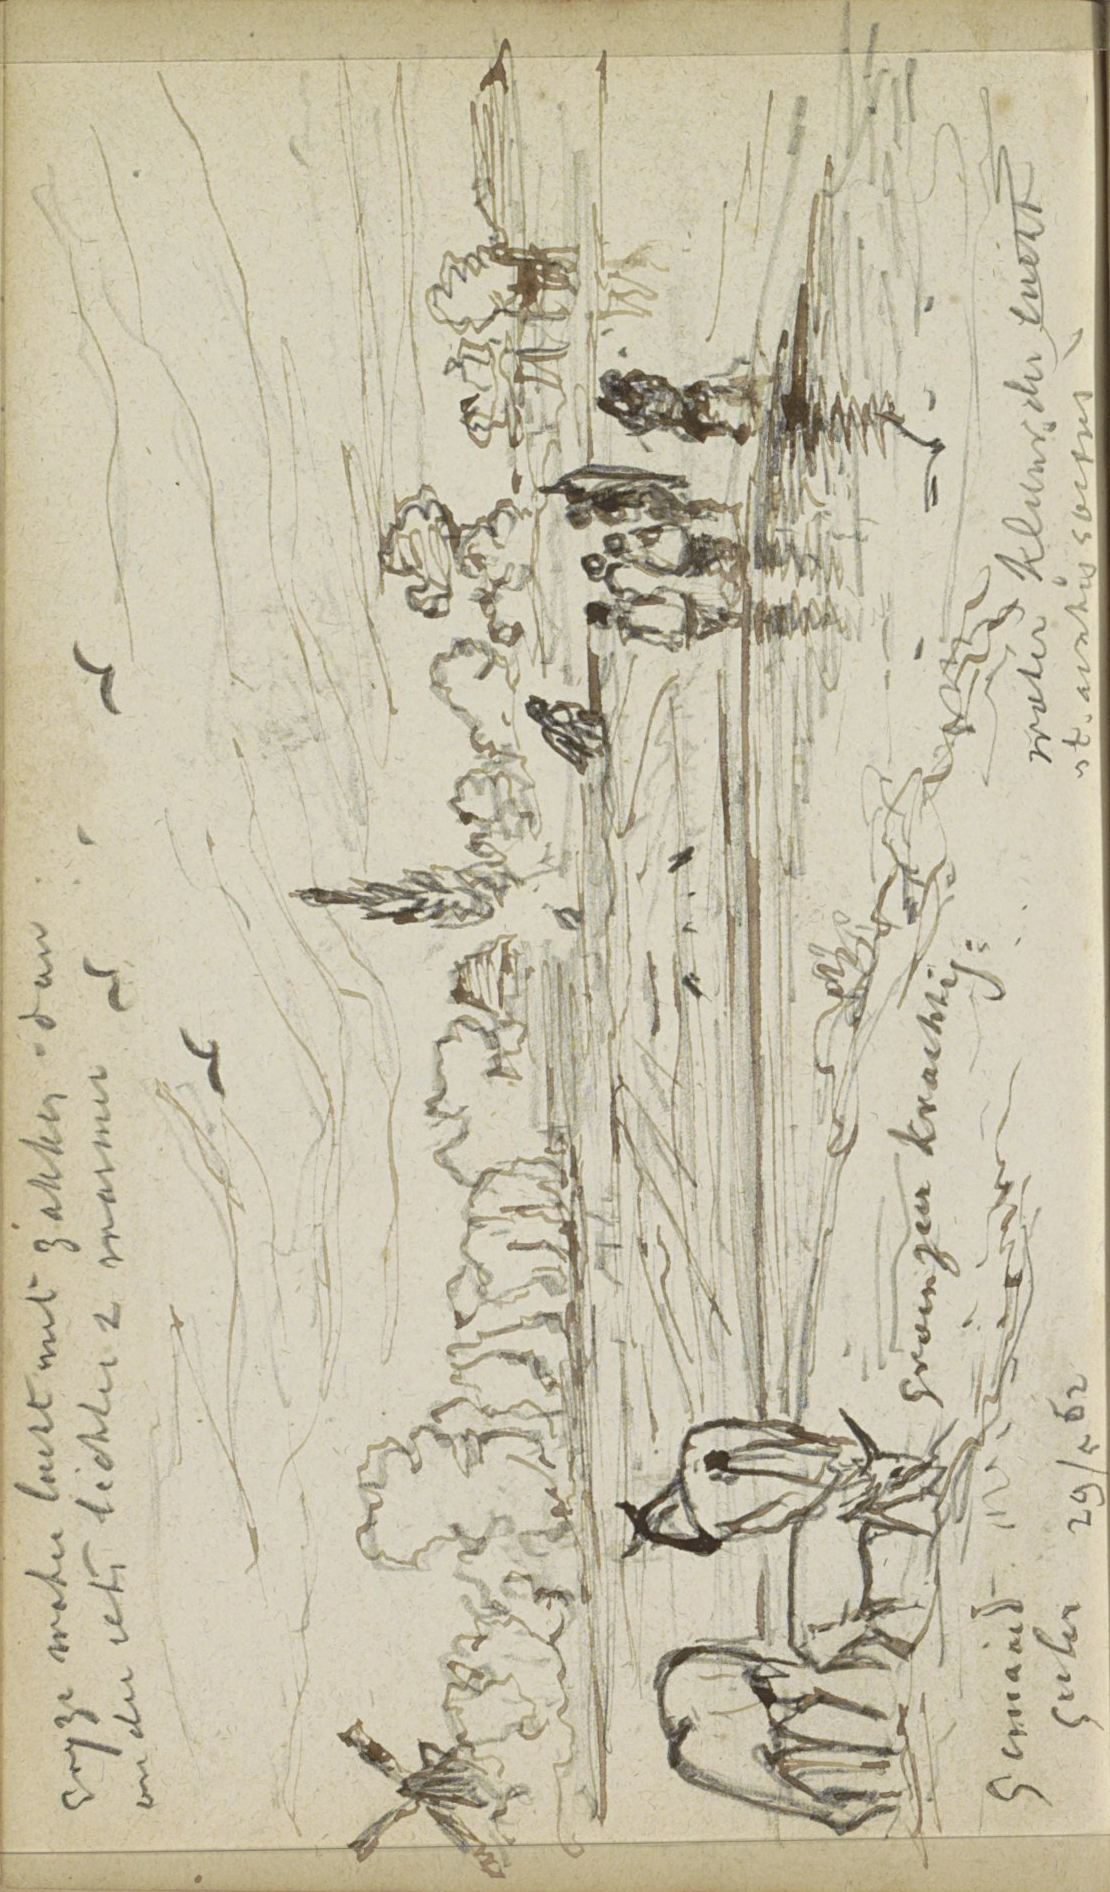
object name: sketchbook leaf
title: Landschap met figuren en grazend vee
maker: johannes tavenraat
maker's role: draughtsman, painter, print maker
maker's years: 1809-1881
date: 1805-1862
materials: ink, paper, pencil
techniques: pen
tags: cattle, meadow, pasture, windmill in landscape, landscapes (+ landscape with figures, staffage)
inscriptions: date: ‘29/5/62’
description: Blad 62 verso uit een schetsboek met 88 bladen.